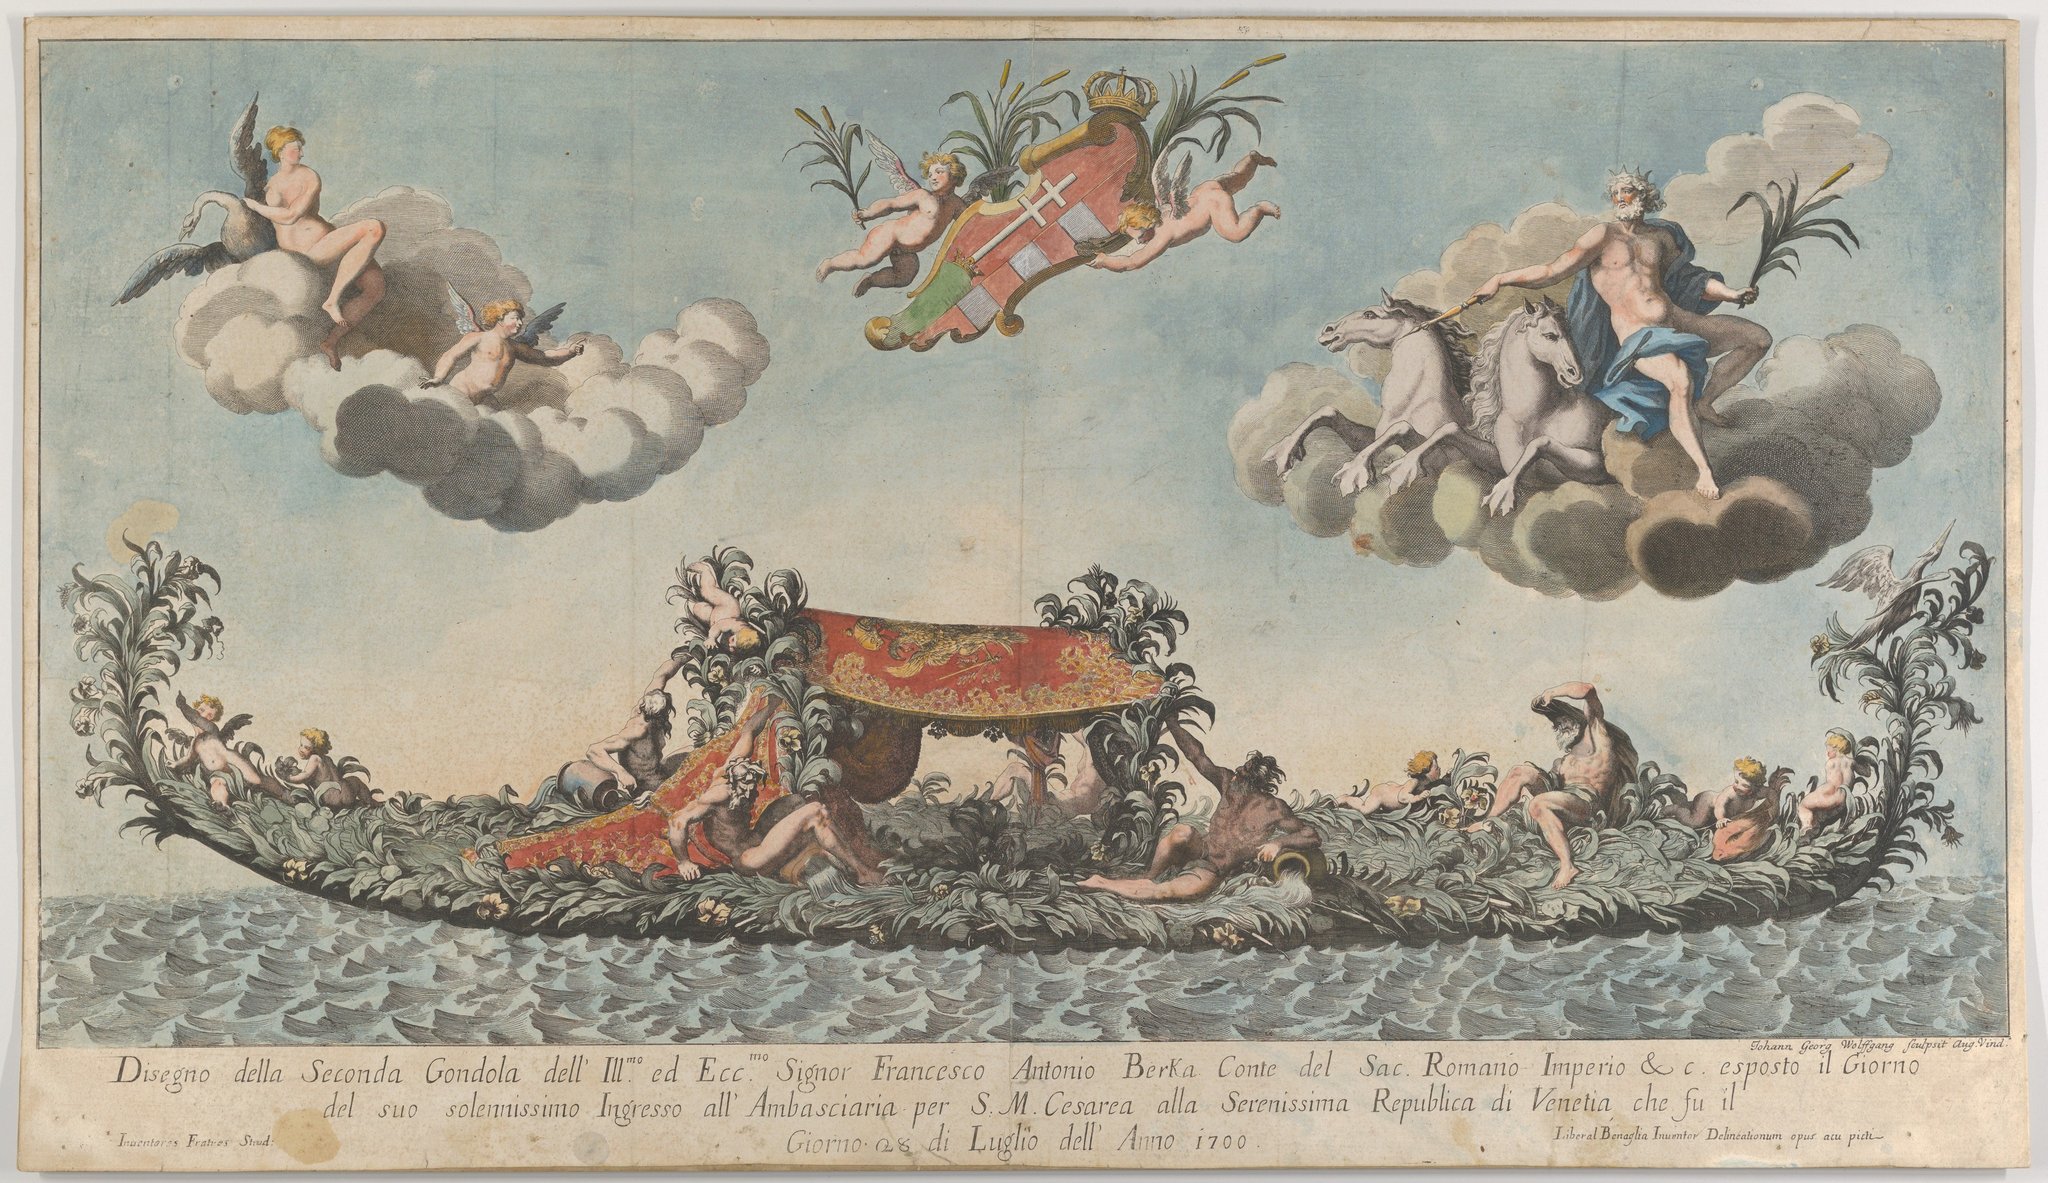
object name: print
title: The highly ornamented second gondola of Francesco Antonio Berka entering Venice, Gods on clouds in the upper section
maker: johann georg wolfgang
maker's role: artist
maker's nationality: german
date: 1700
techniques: engraving, etching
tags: birds,male nudes,female nudes,horses,boats